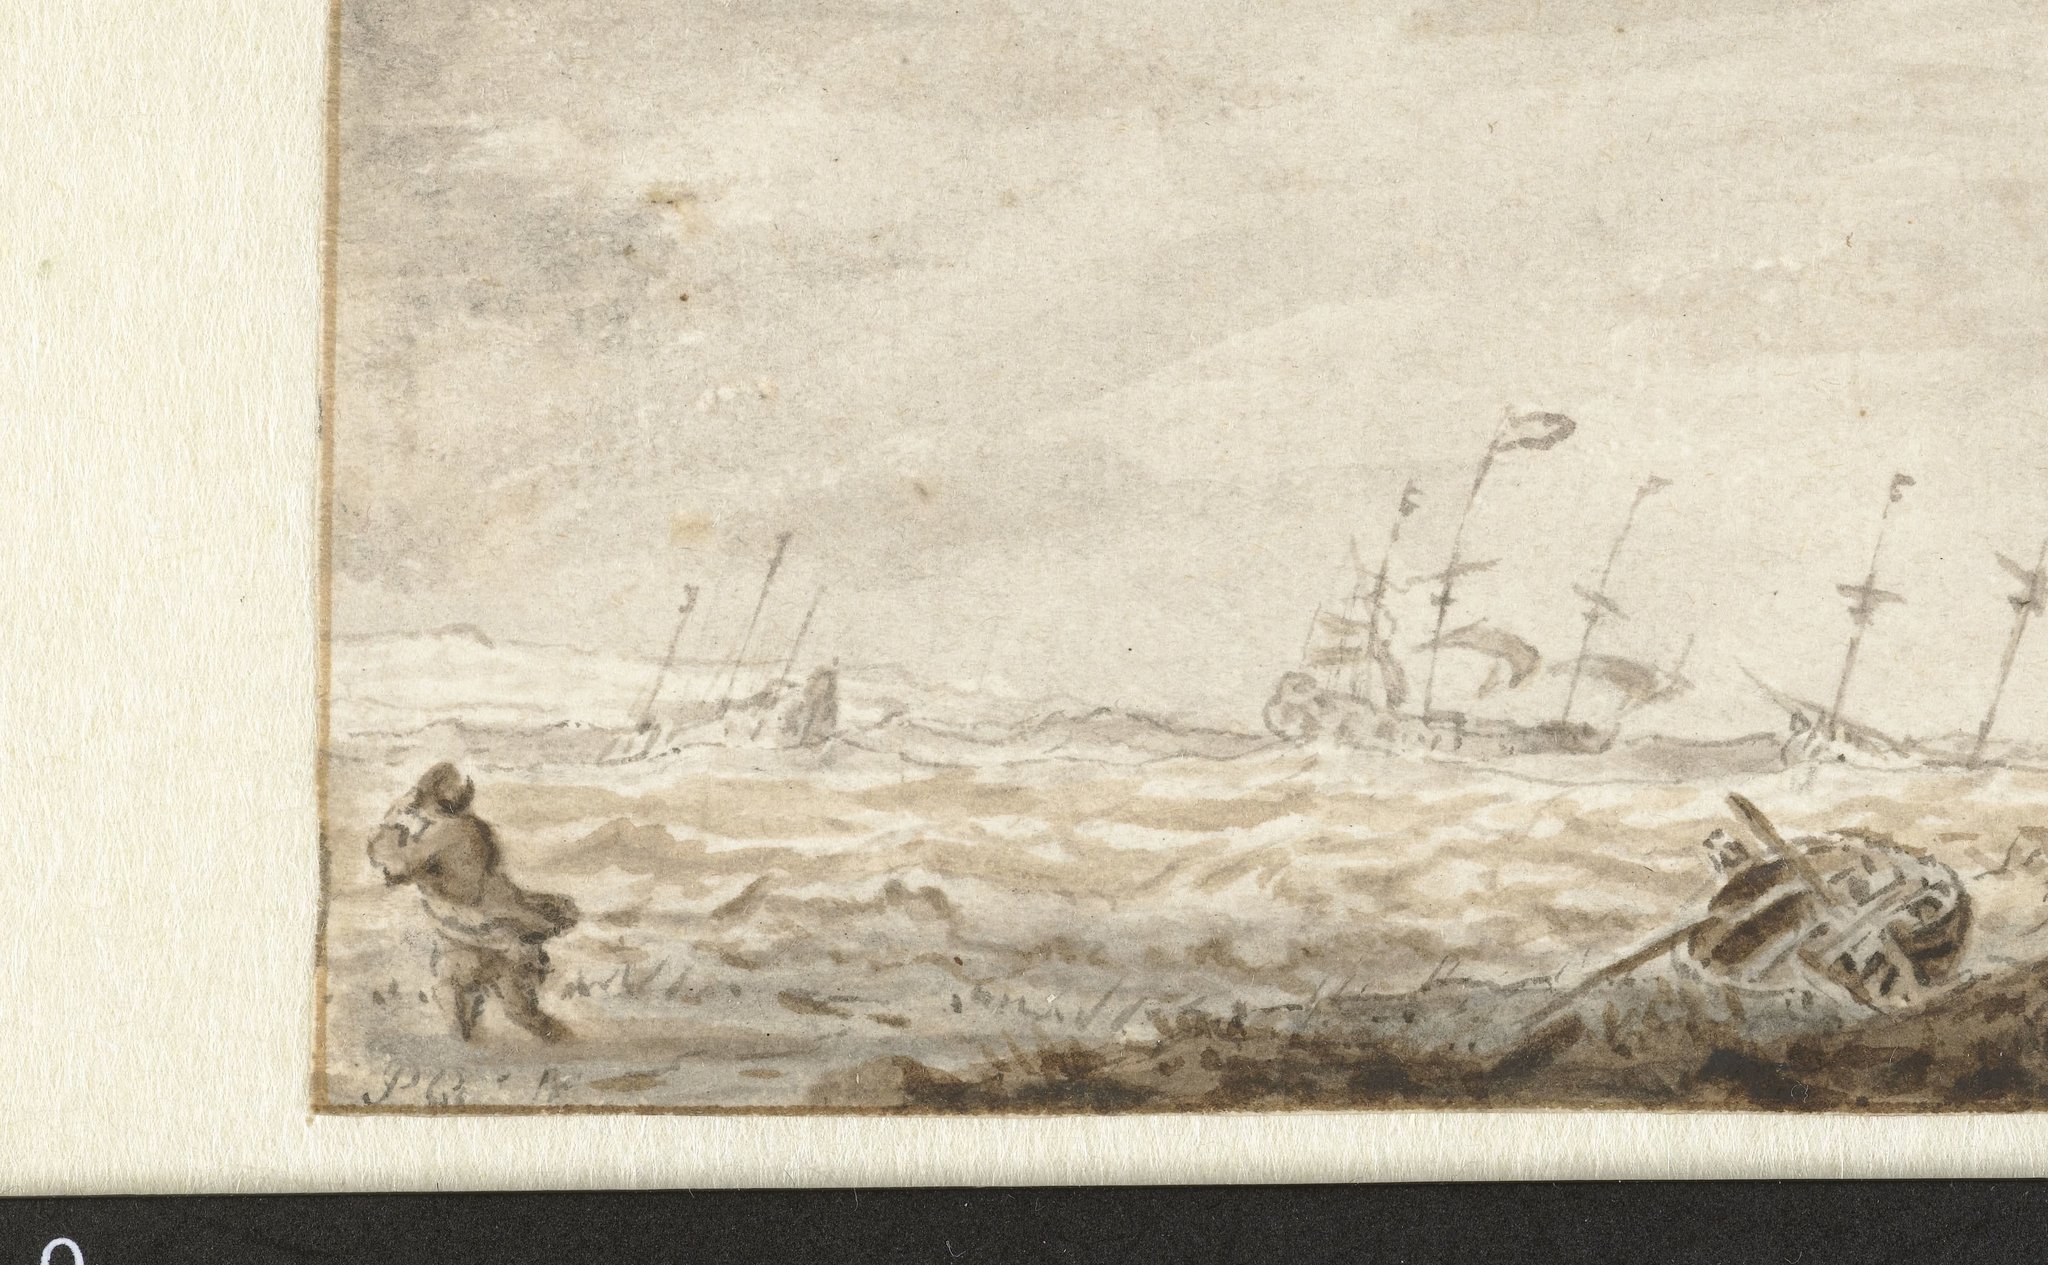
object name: drawing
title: Zeilschepen op ruwe zee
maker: pieter coopse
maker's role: draughtsman, print maker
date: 1668-1677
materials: ink, paper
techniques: brush, pen